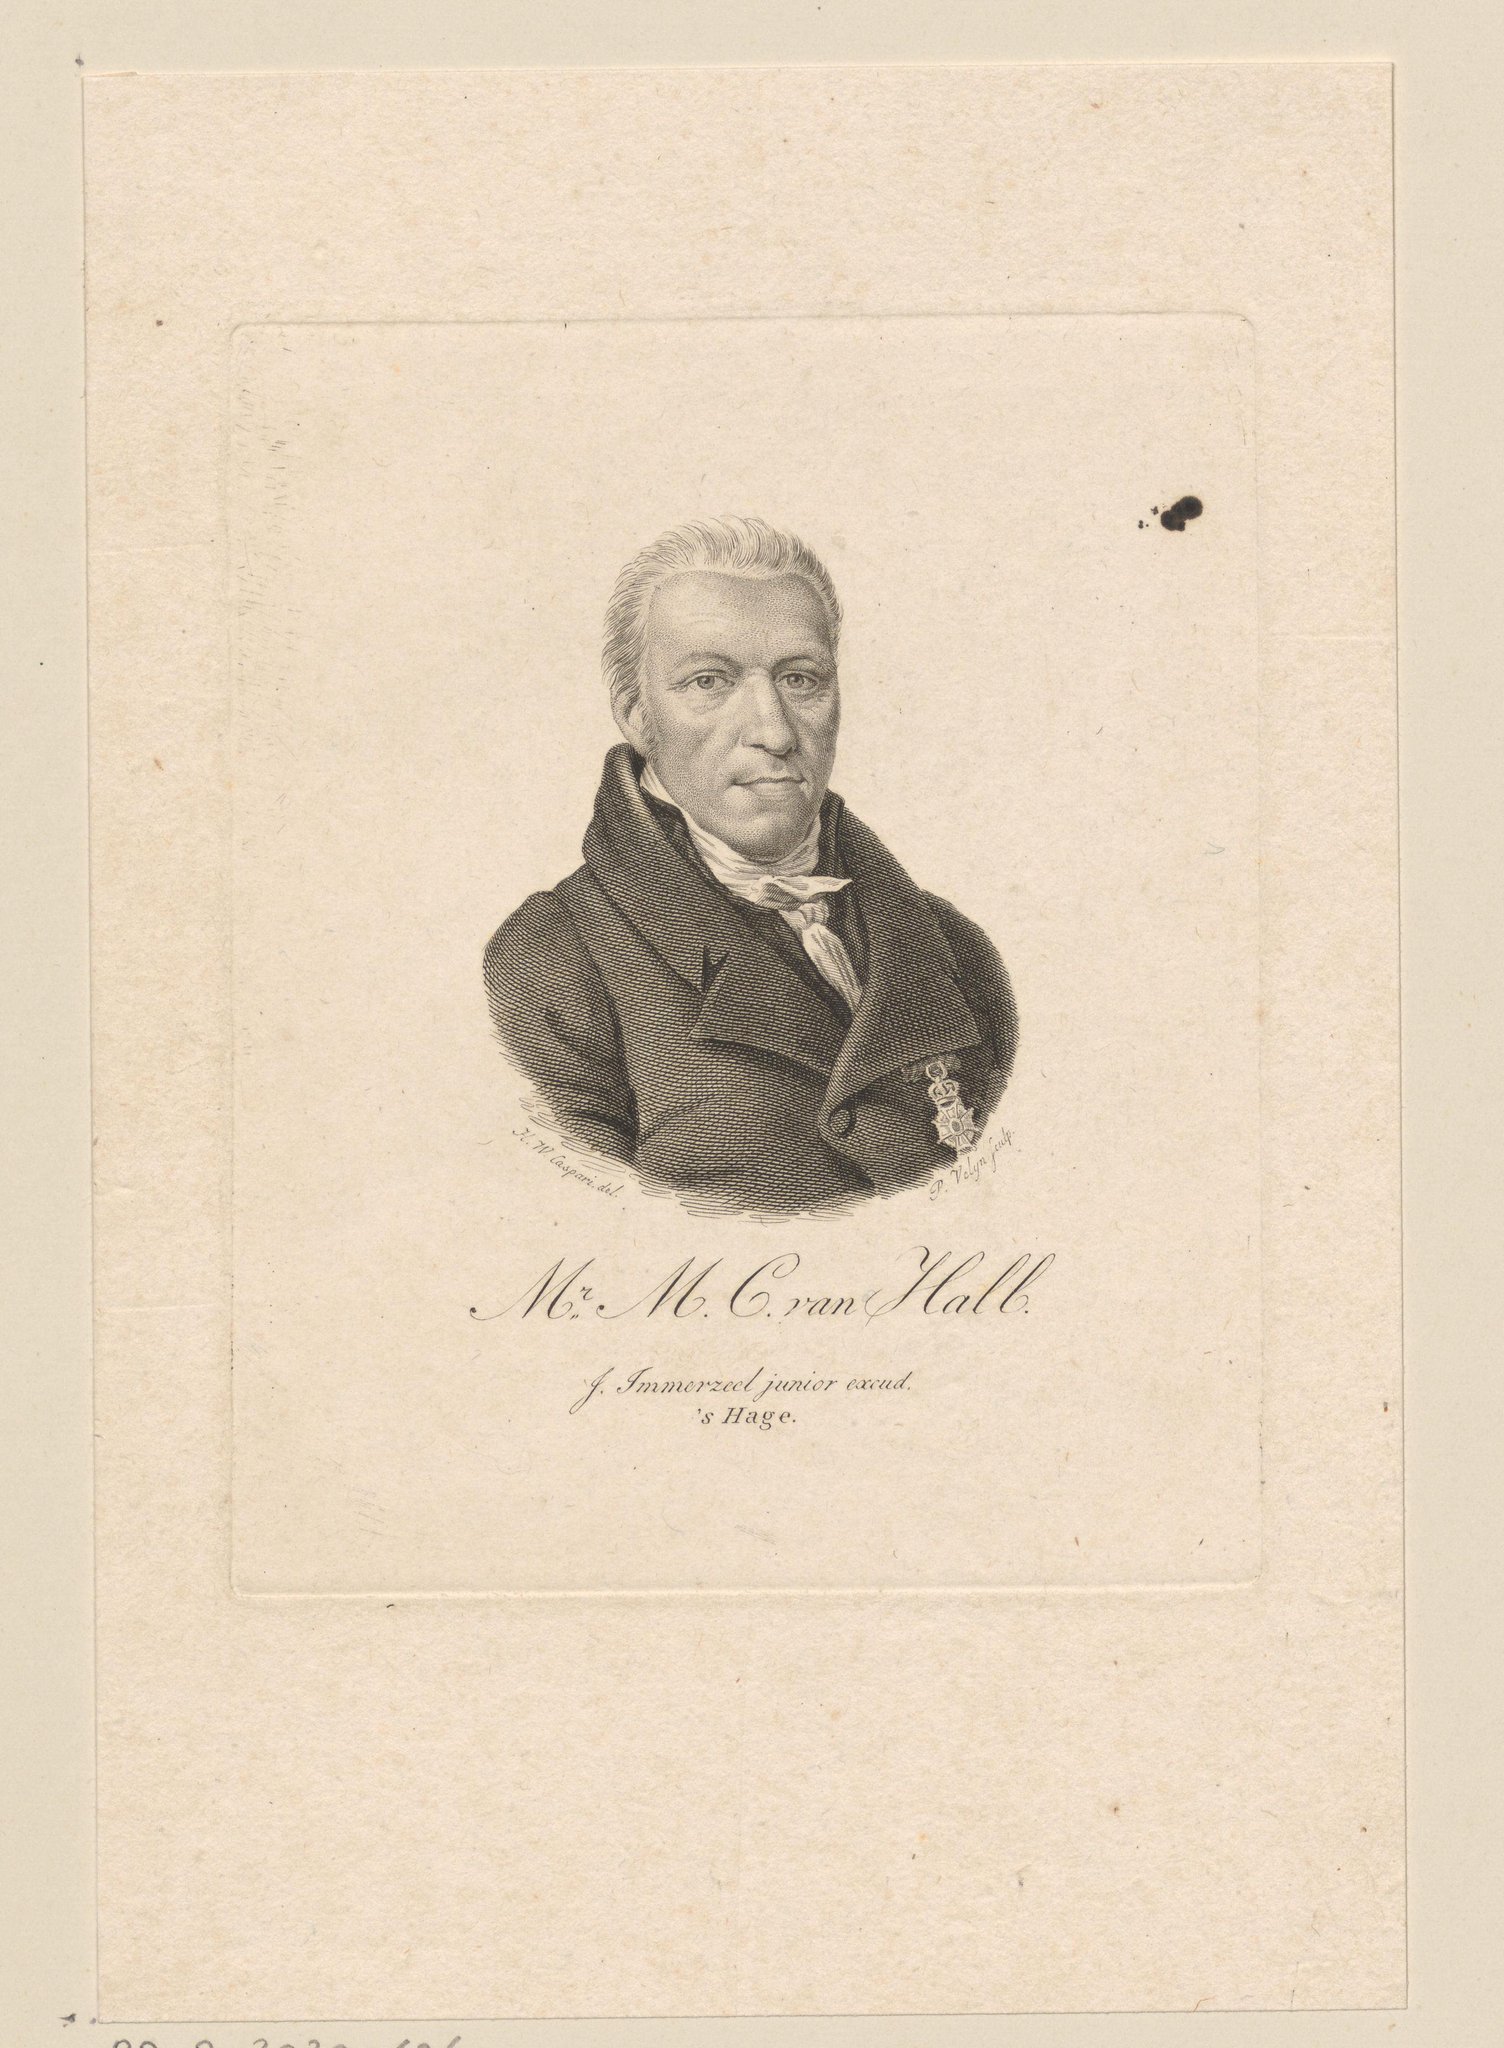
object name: print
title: Portret van Maurits Cornelis van Hall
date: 1826-1832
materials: paper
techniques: engraving, etching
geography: the hague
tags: amsterdam, maurits cornelis van hall, historical persons, lawyer, attorney at law